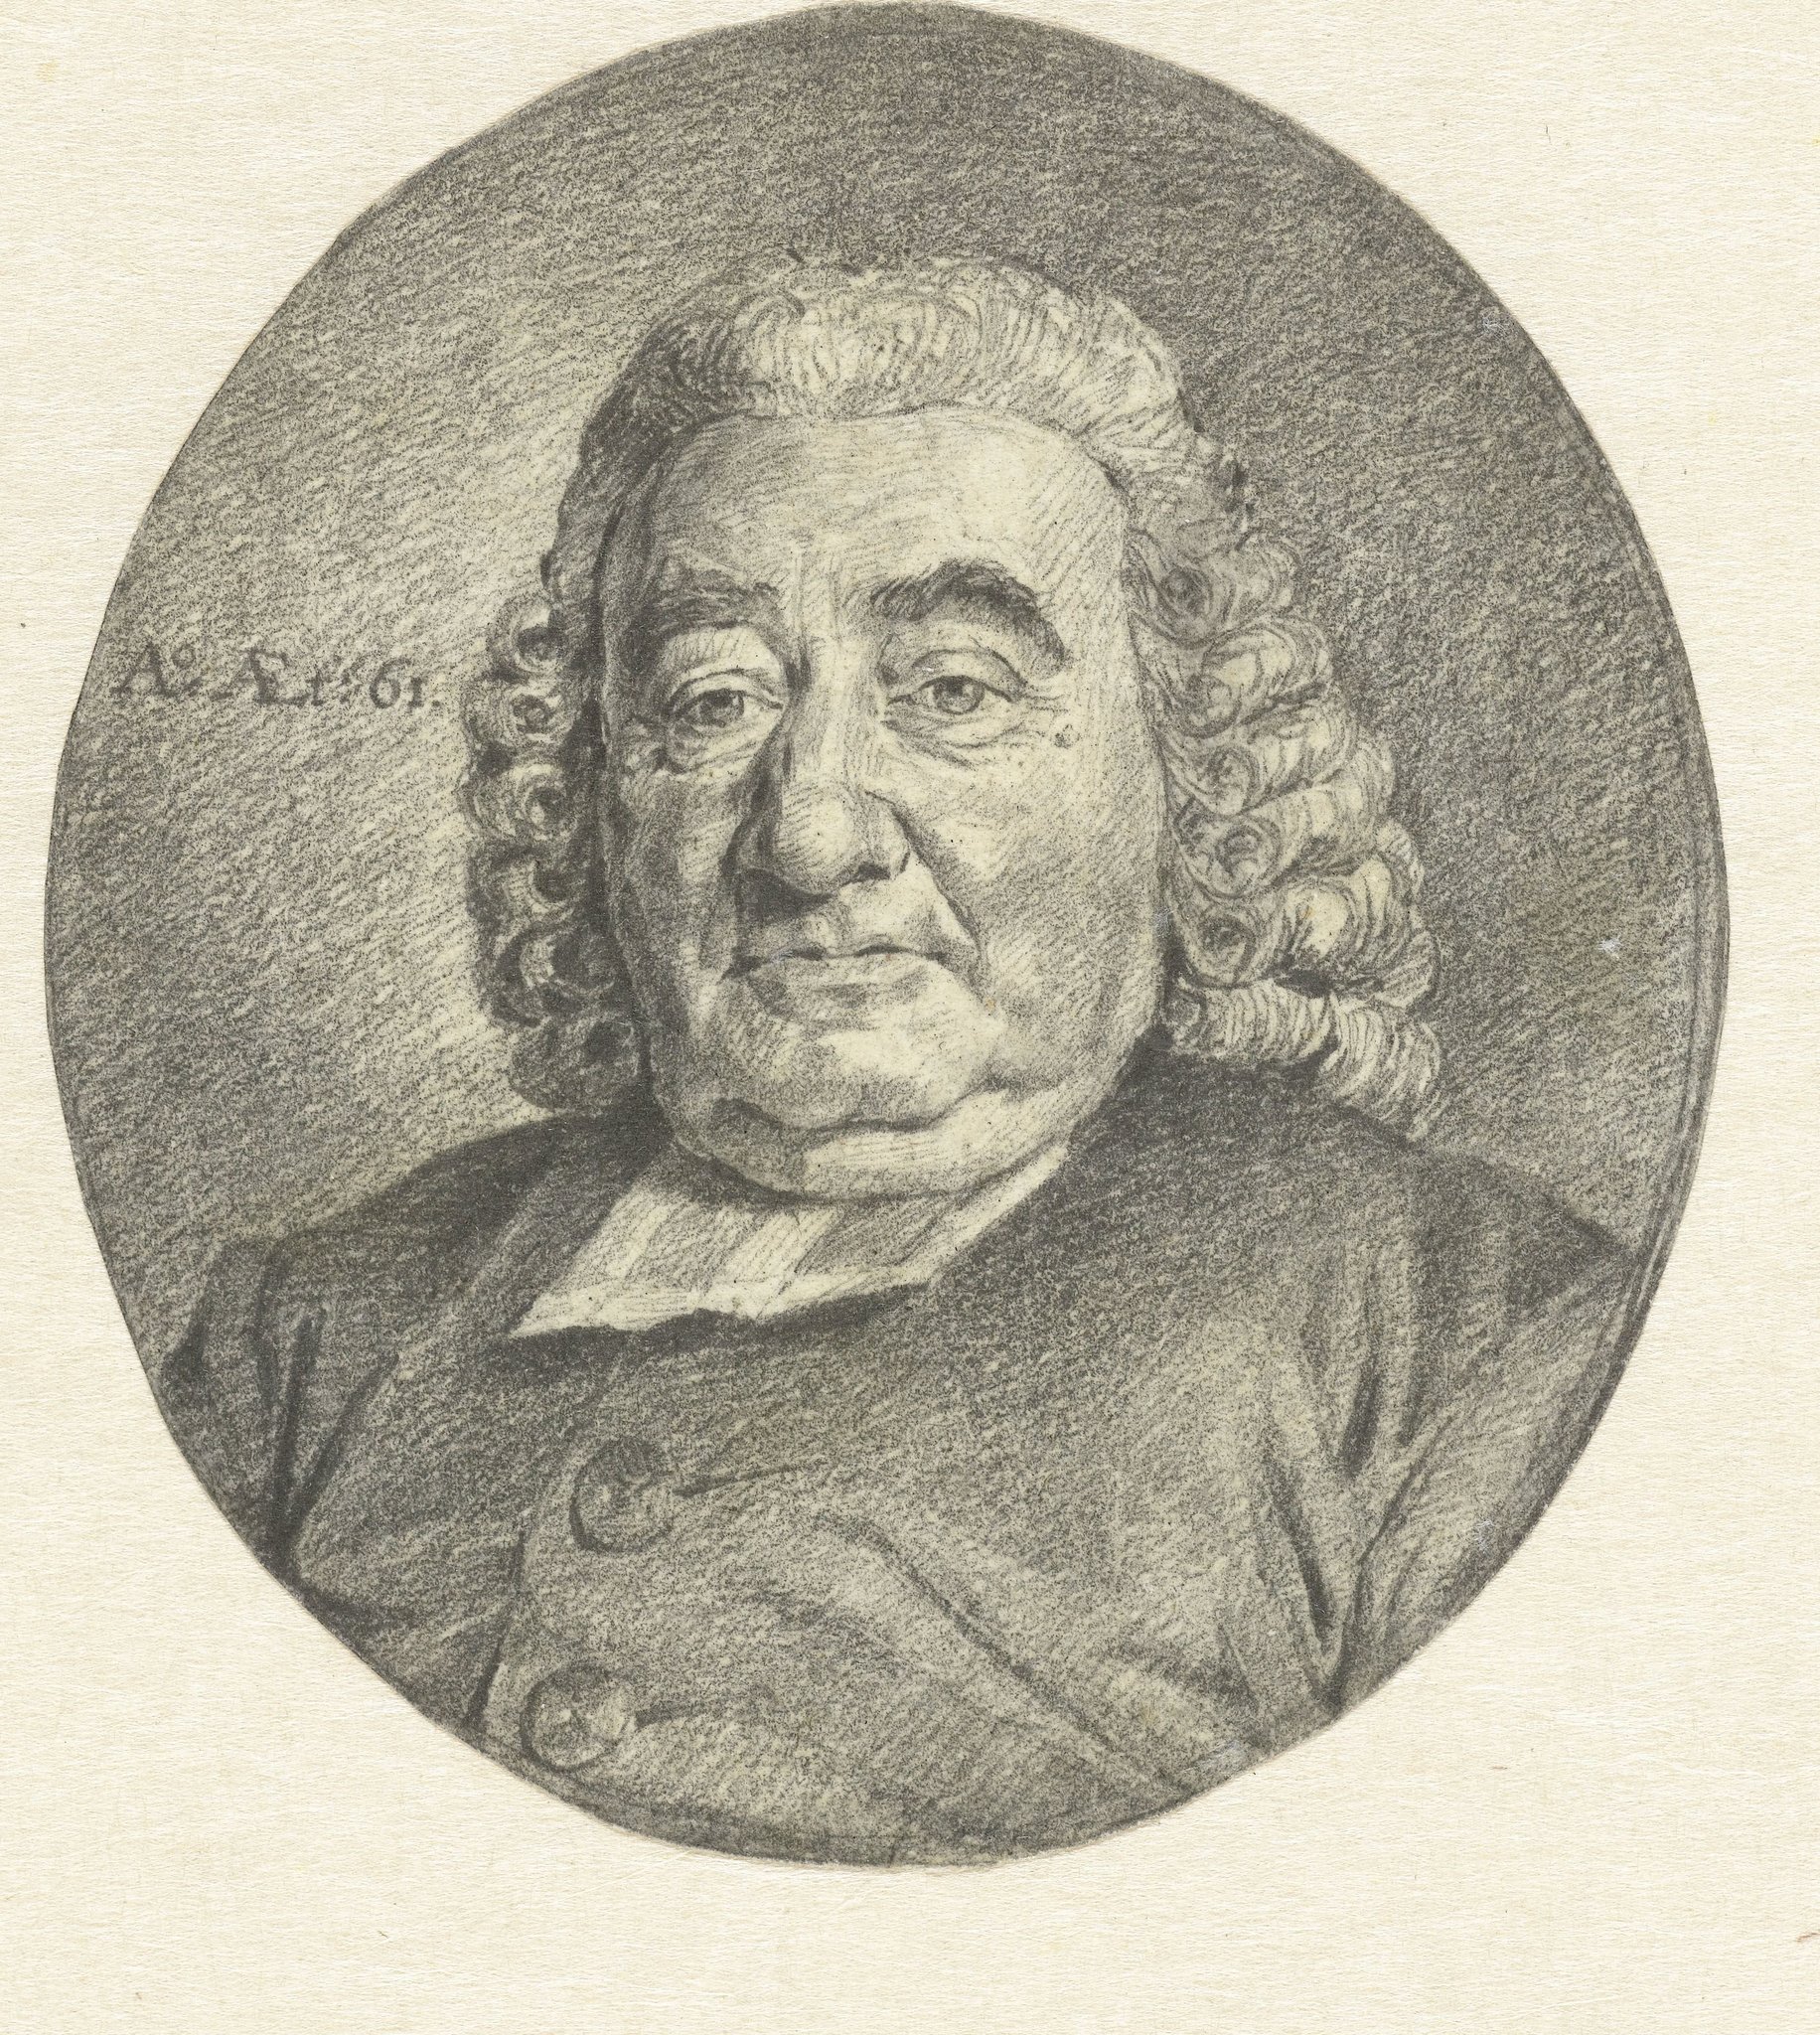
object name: drawing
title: Portret van Henrik Antoni Tollé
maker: jacob schwartzenbach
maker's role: draughtsman, painter, print maker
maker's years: 1763-1805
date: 1781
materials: chalk, paper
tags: historical persons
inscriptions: inscription: ‘Ao. AEt: 61’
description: Portret van Henrik Antoni Tollé, predikant te Veere.